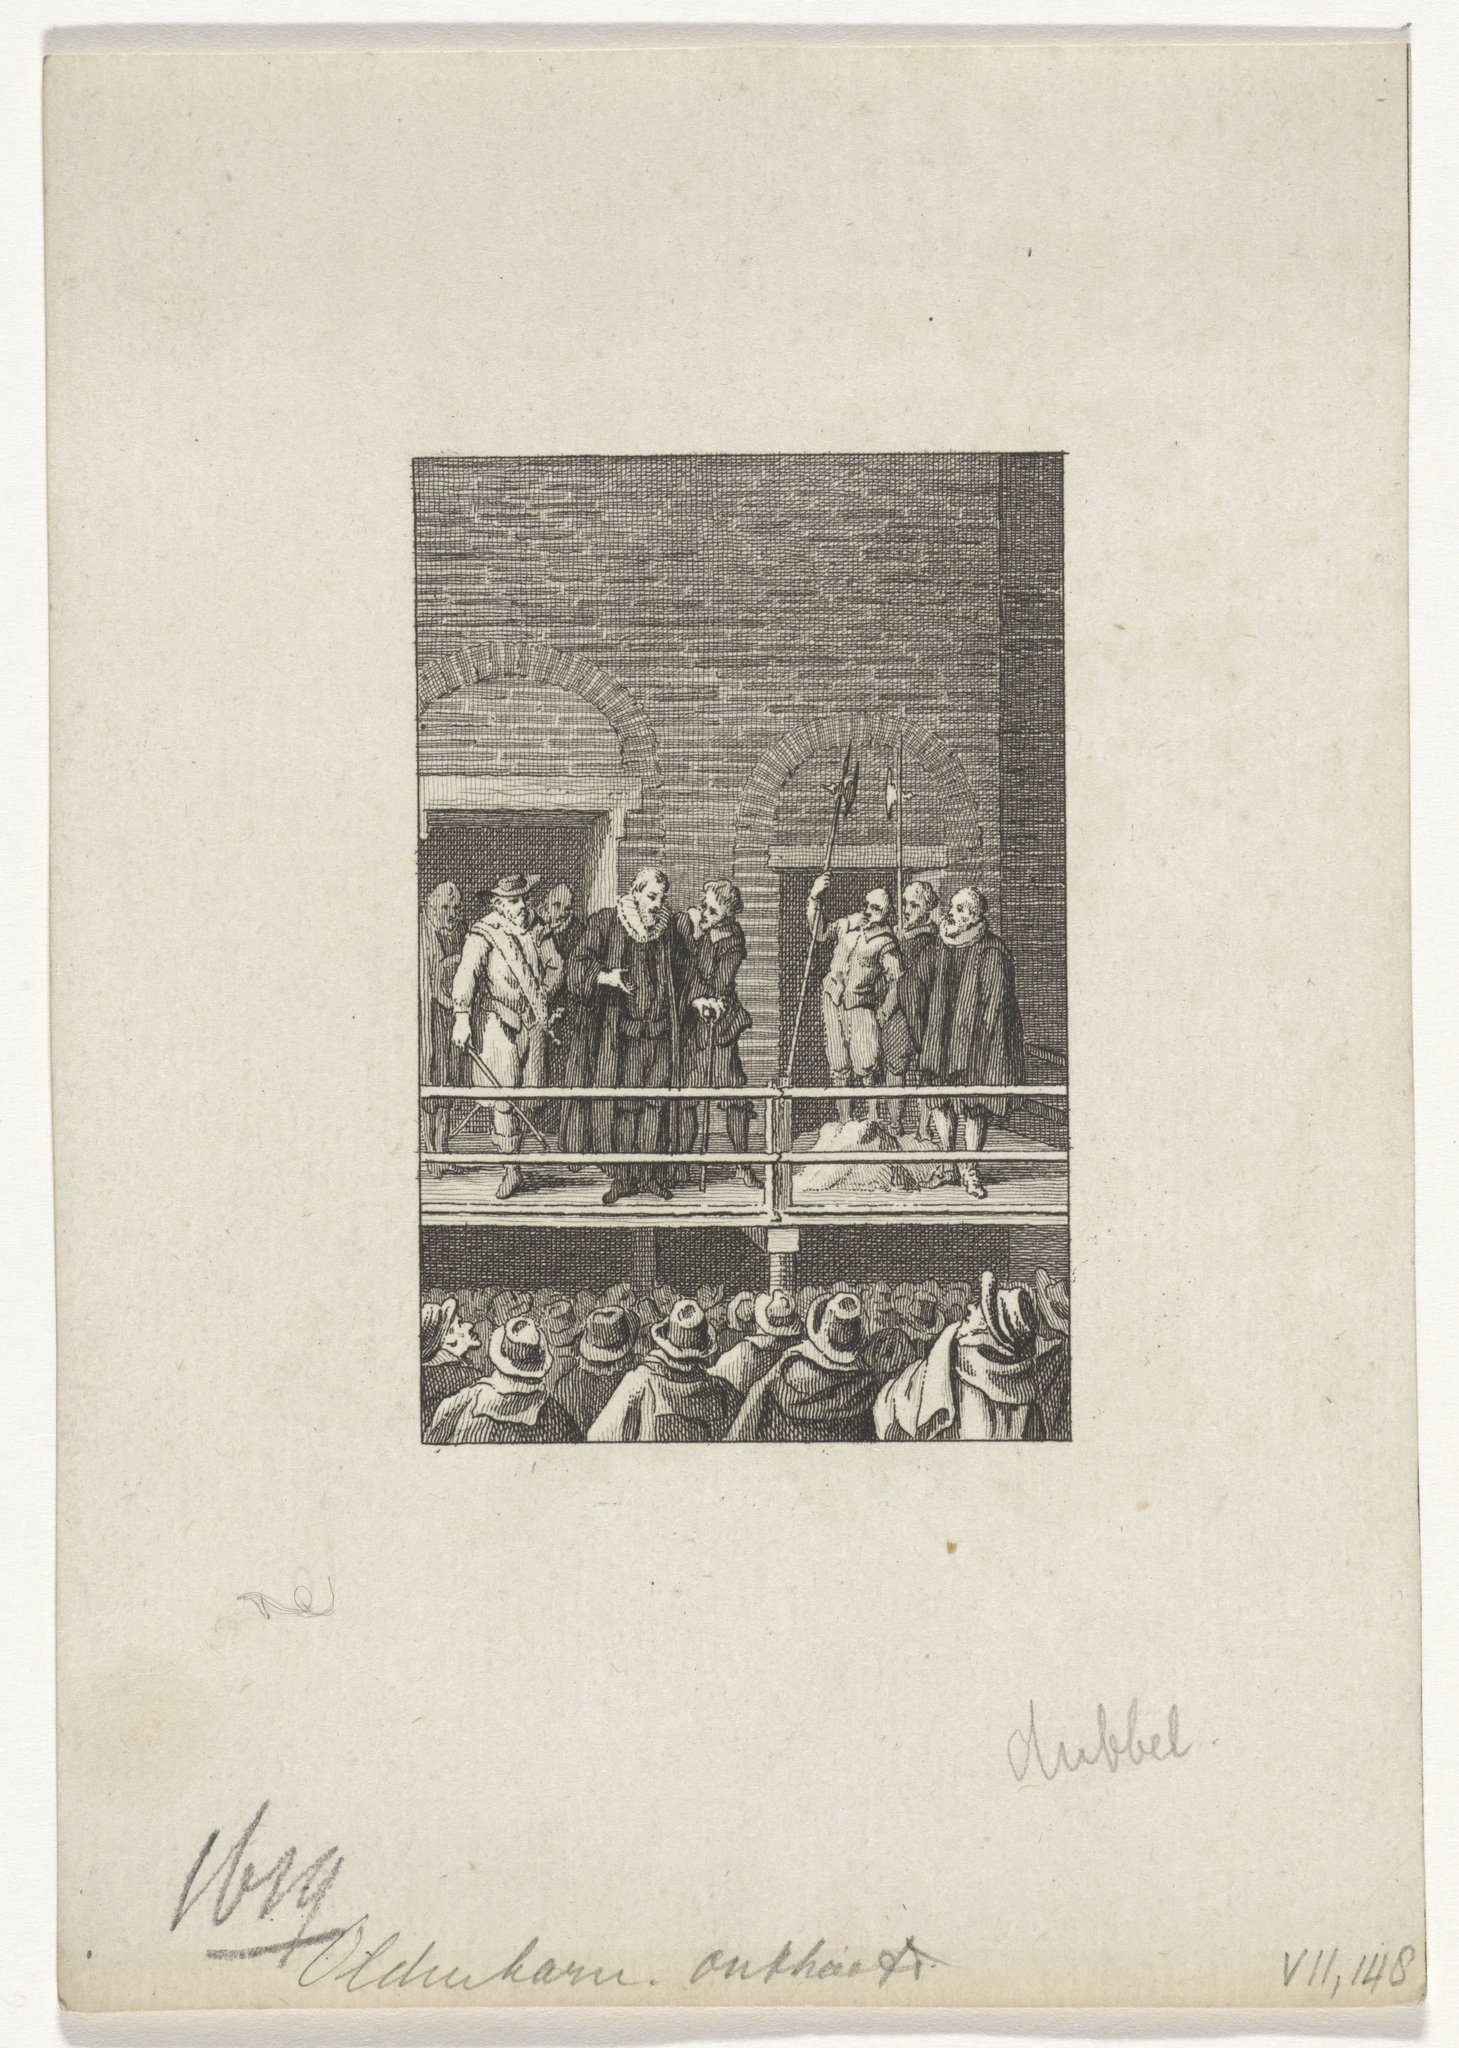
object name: print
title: Johan van Oldenbarnevelt spreekt vanaf het schavot voor zijn onthoofding de omstanders toe, 13 mei 1619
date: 1783-1795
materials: paper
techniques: etching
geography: amsterdam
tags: the hague, johan van oldenbarnevelt, on the scaffold or place of execution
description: Illustratie voor: J. Fokke. Geschiedenissen der Vereenigde Nederlanden voor de vaderlandsche jeugd. Amsterdam: Johannes Allart, 1783-1795, 25 delen. deel VII pl. II.